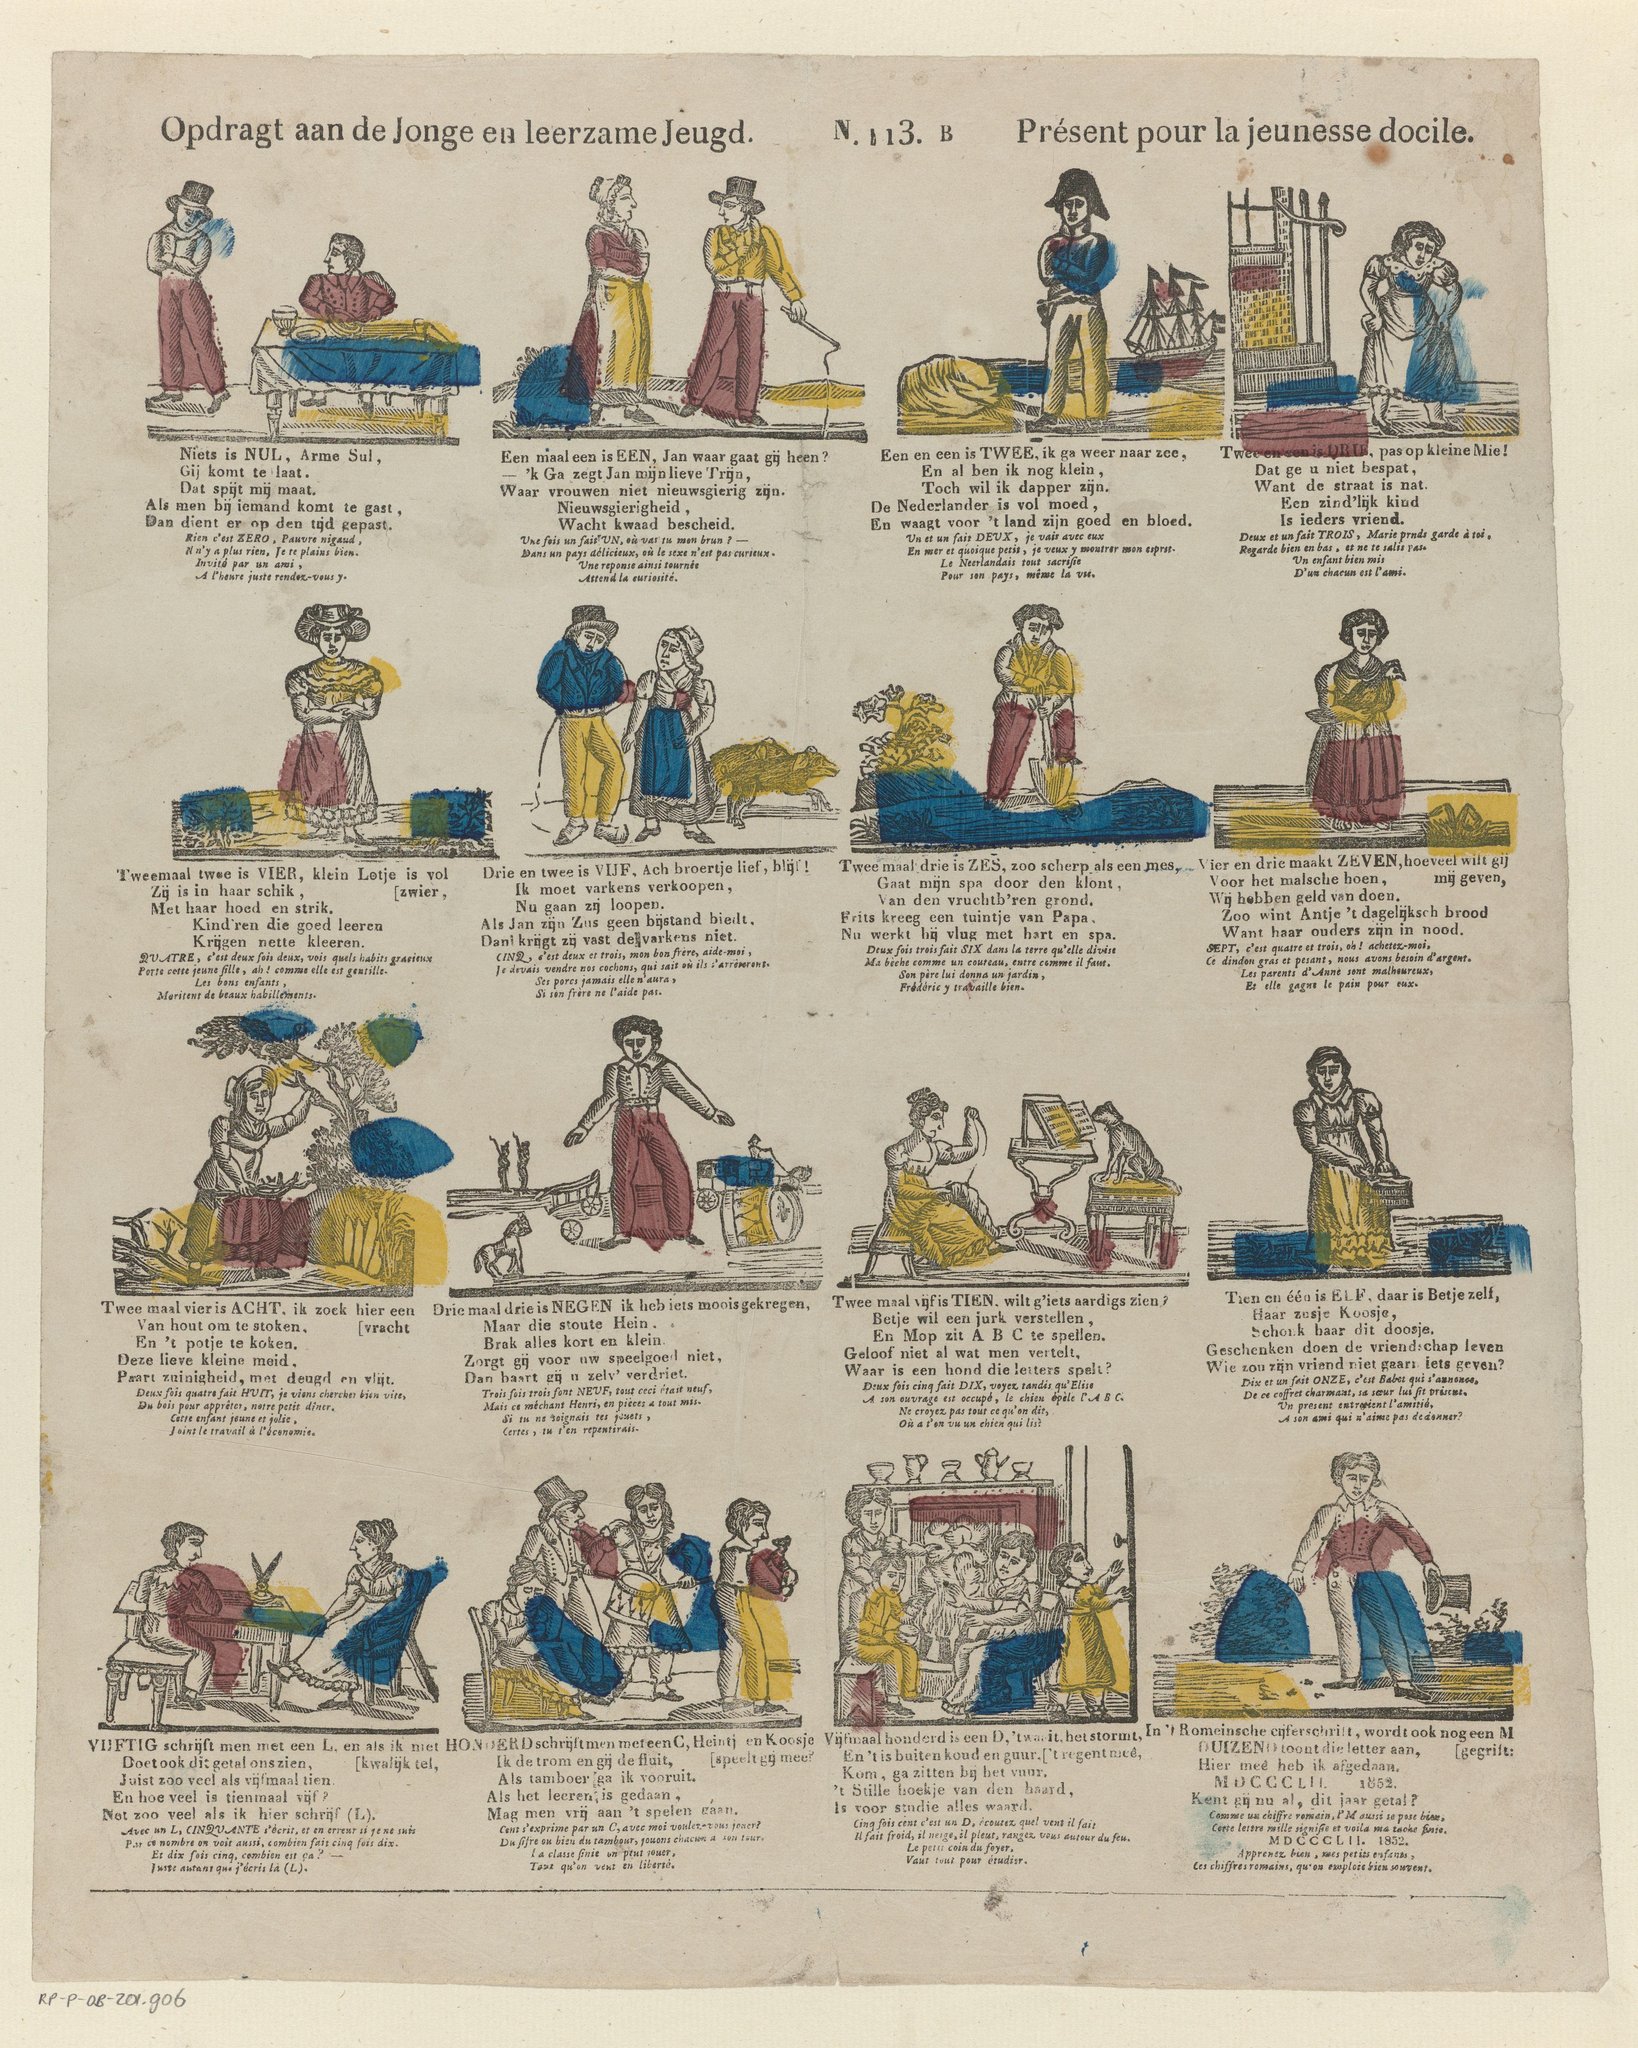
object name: print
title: Opdragt aan de jonge en leerzame jeugd / Présent pour la jeunesse docile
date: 1800-1833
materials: paper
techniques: colour, letterpress printing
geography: turnhout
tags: counting, calculating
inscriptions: collector's mark: Lugt 2760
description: Blad met 16 voorstellingen van verschillende aard met versjes over rekenen (rekenles) in het Nederlands en in het Frans. Genummerd midden boven: N. 113. B.